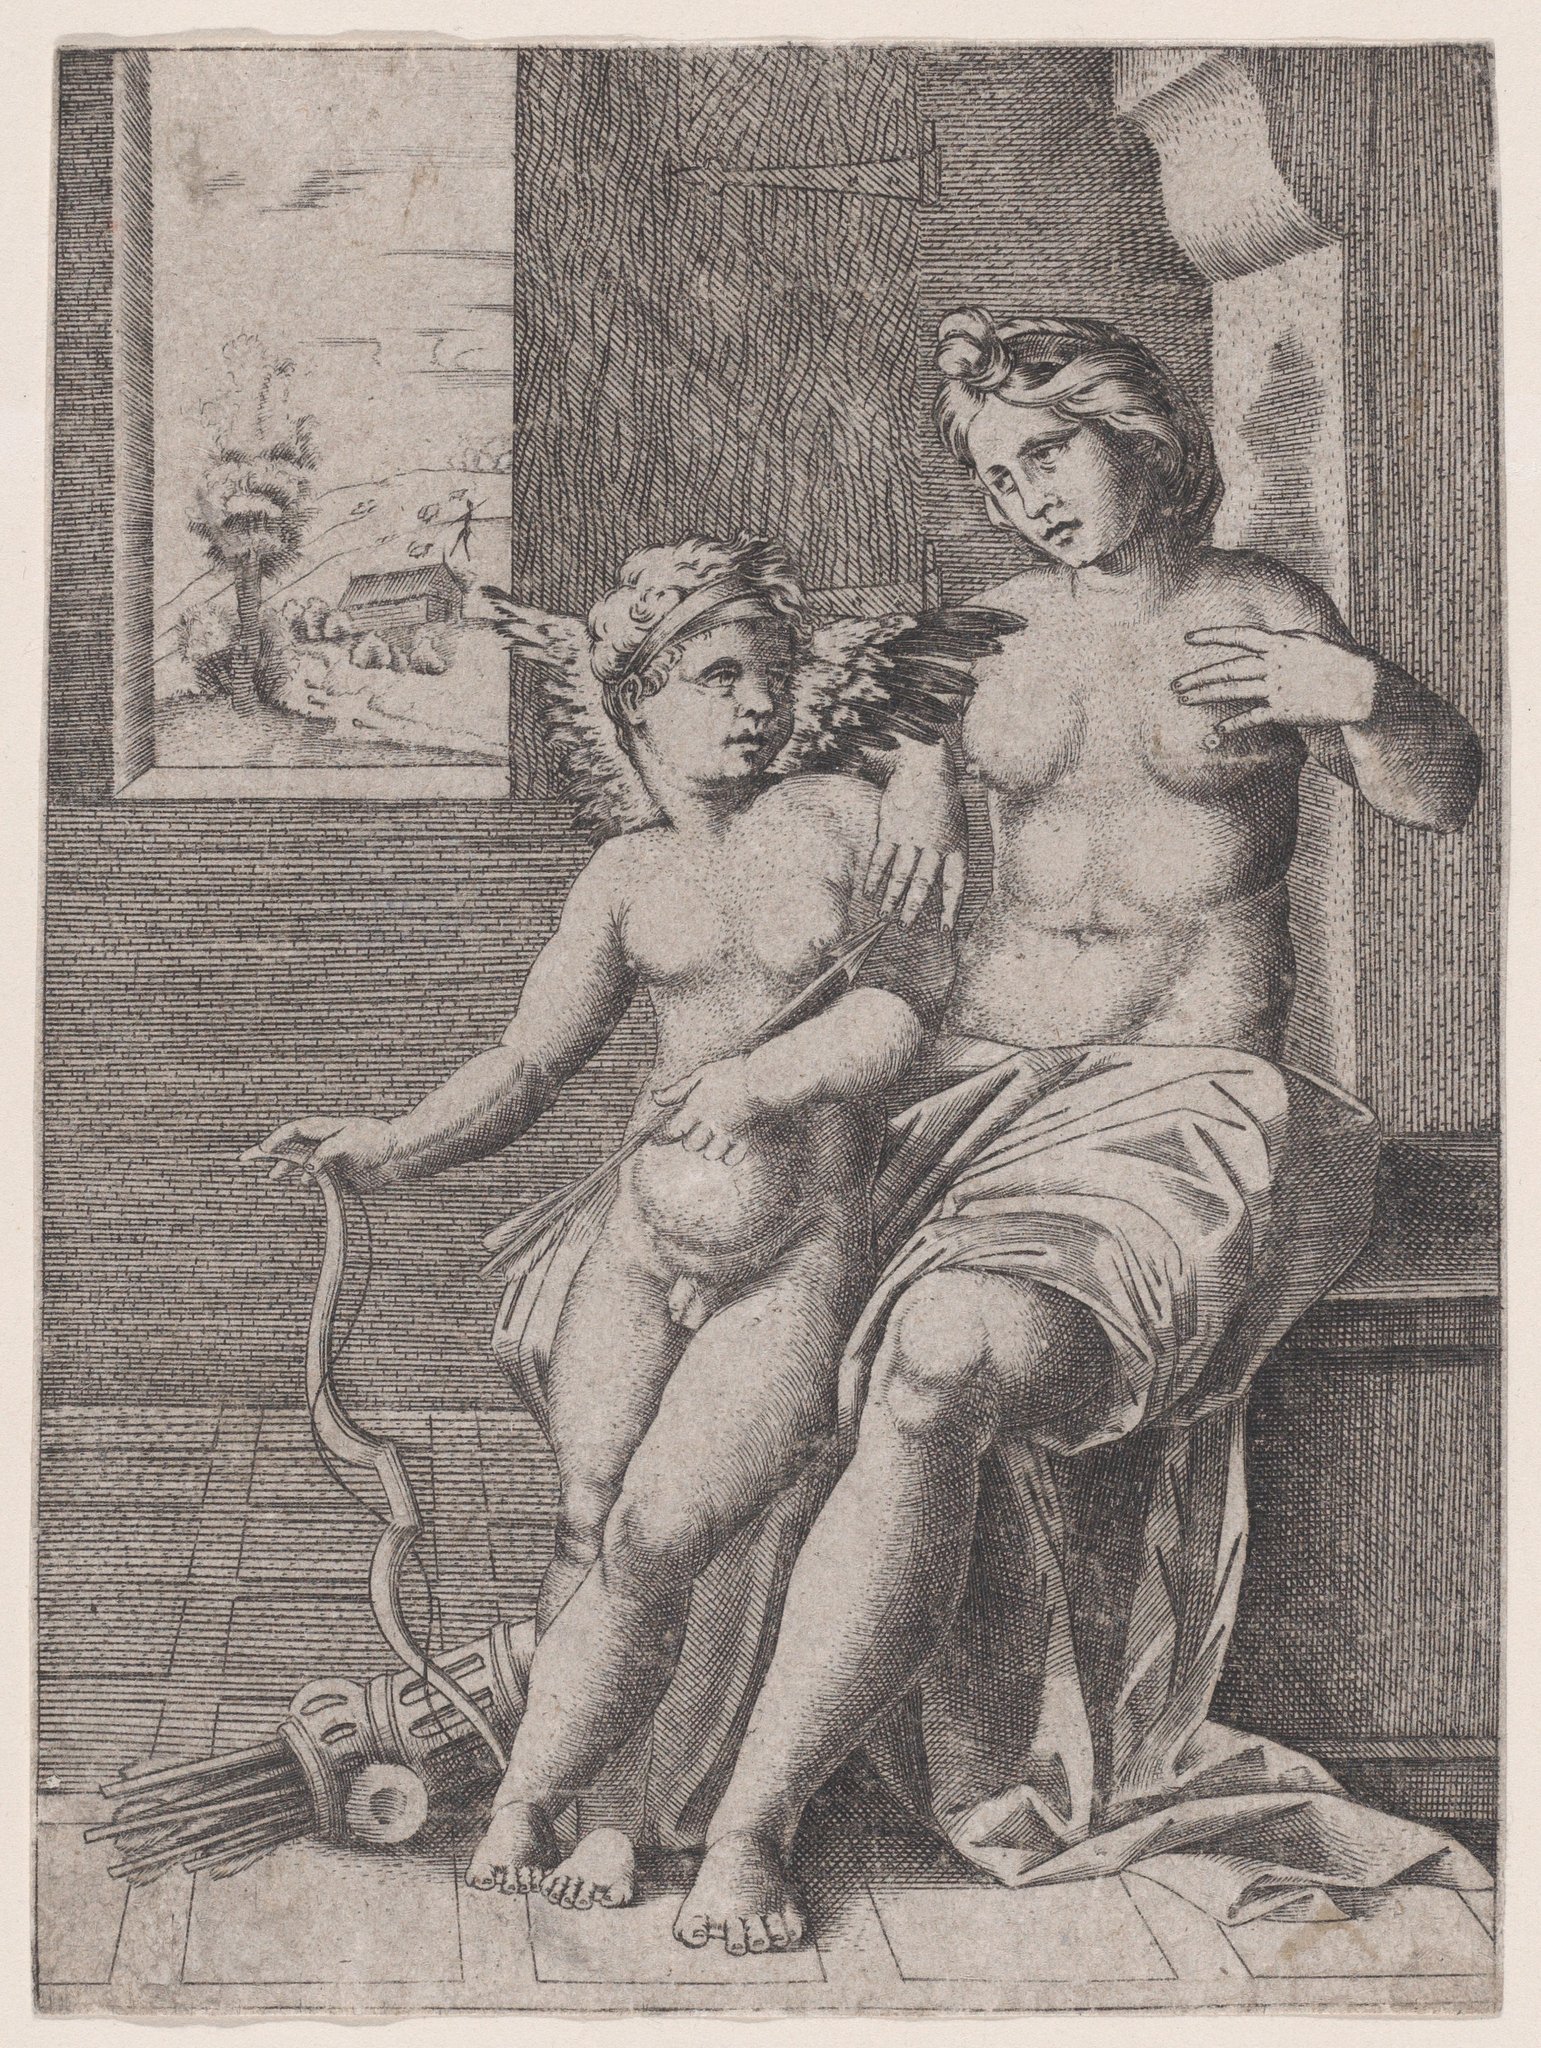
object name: print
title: Venus and Eros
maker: anonymous, italian, 16th to early 17th century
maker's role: artist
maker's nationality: italian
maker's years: 1500-1640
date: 1514-1536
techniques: engraving